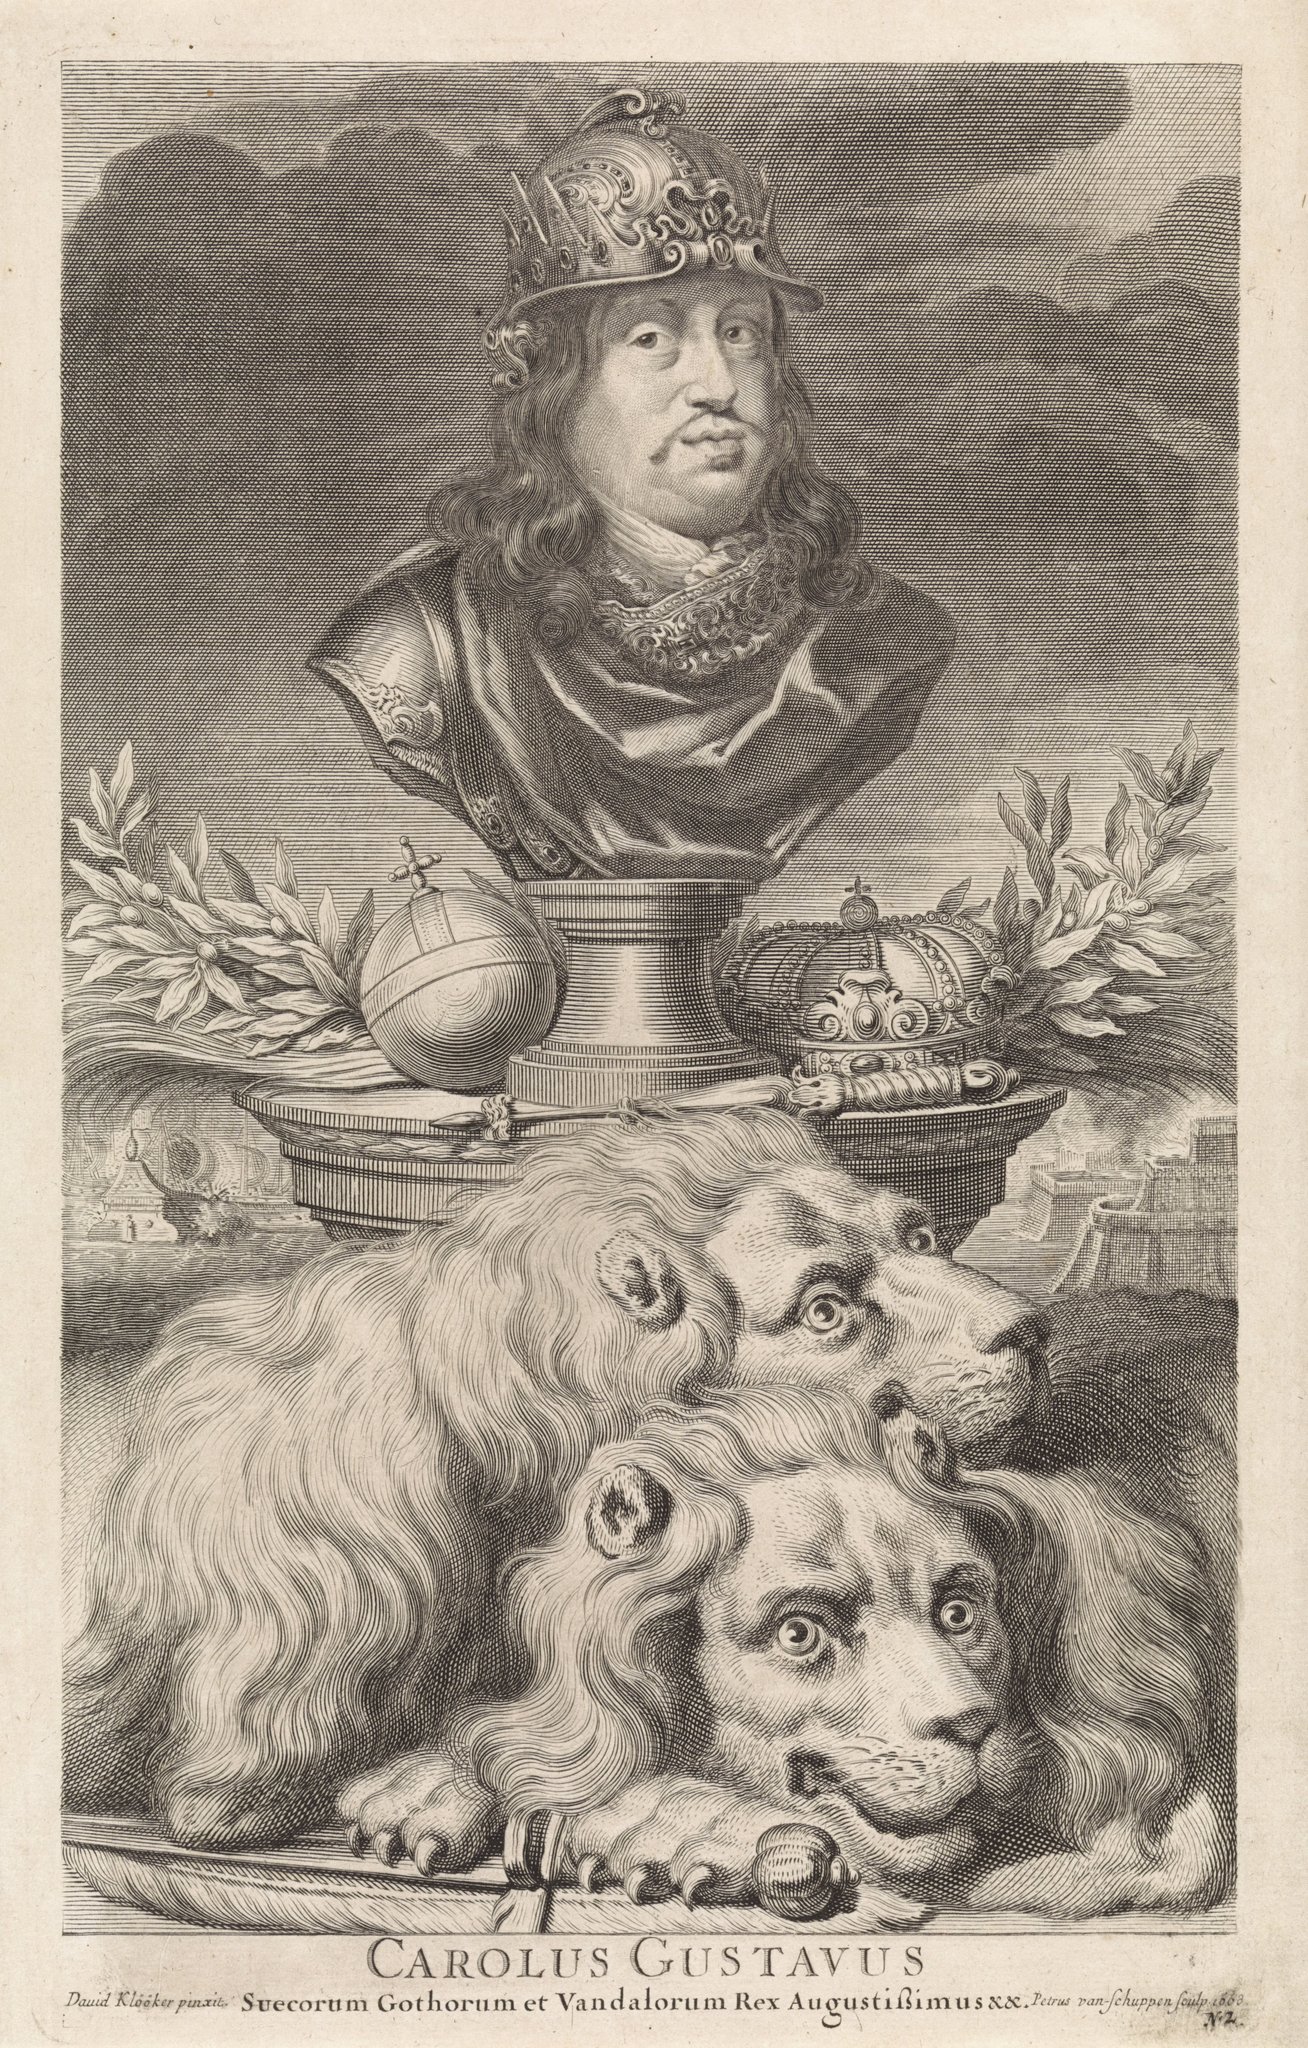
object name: print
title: Portret van Karel XI, koning van Zweden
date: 1668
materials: paper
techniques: engraving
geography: paris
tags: crown (symbol of sovereignty), beasts of prey, predatory animals: lion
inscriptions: collector's mark: Lugt 2228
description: Portret van Karel XI, koning van Zweden, als gebeeldhouwde buste op een piëdestal. Hij draagt een rijkversierde helm, Op het voetstuk liggen zijn scepter, kroon en rijksappel en enkele lauwertakken, Ervoor liggen twee leeuwen. Op de achtergrond zijn een burcht en een oorlogsschip te zien. Onder de afbeelding twee regels tekst in het Latijn met zijn naam en titel. In de rechterbenedenhoek 'No. 2'.